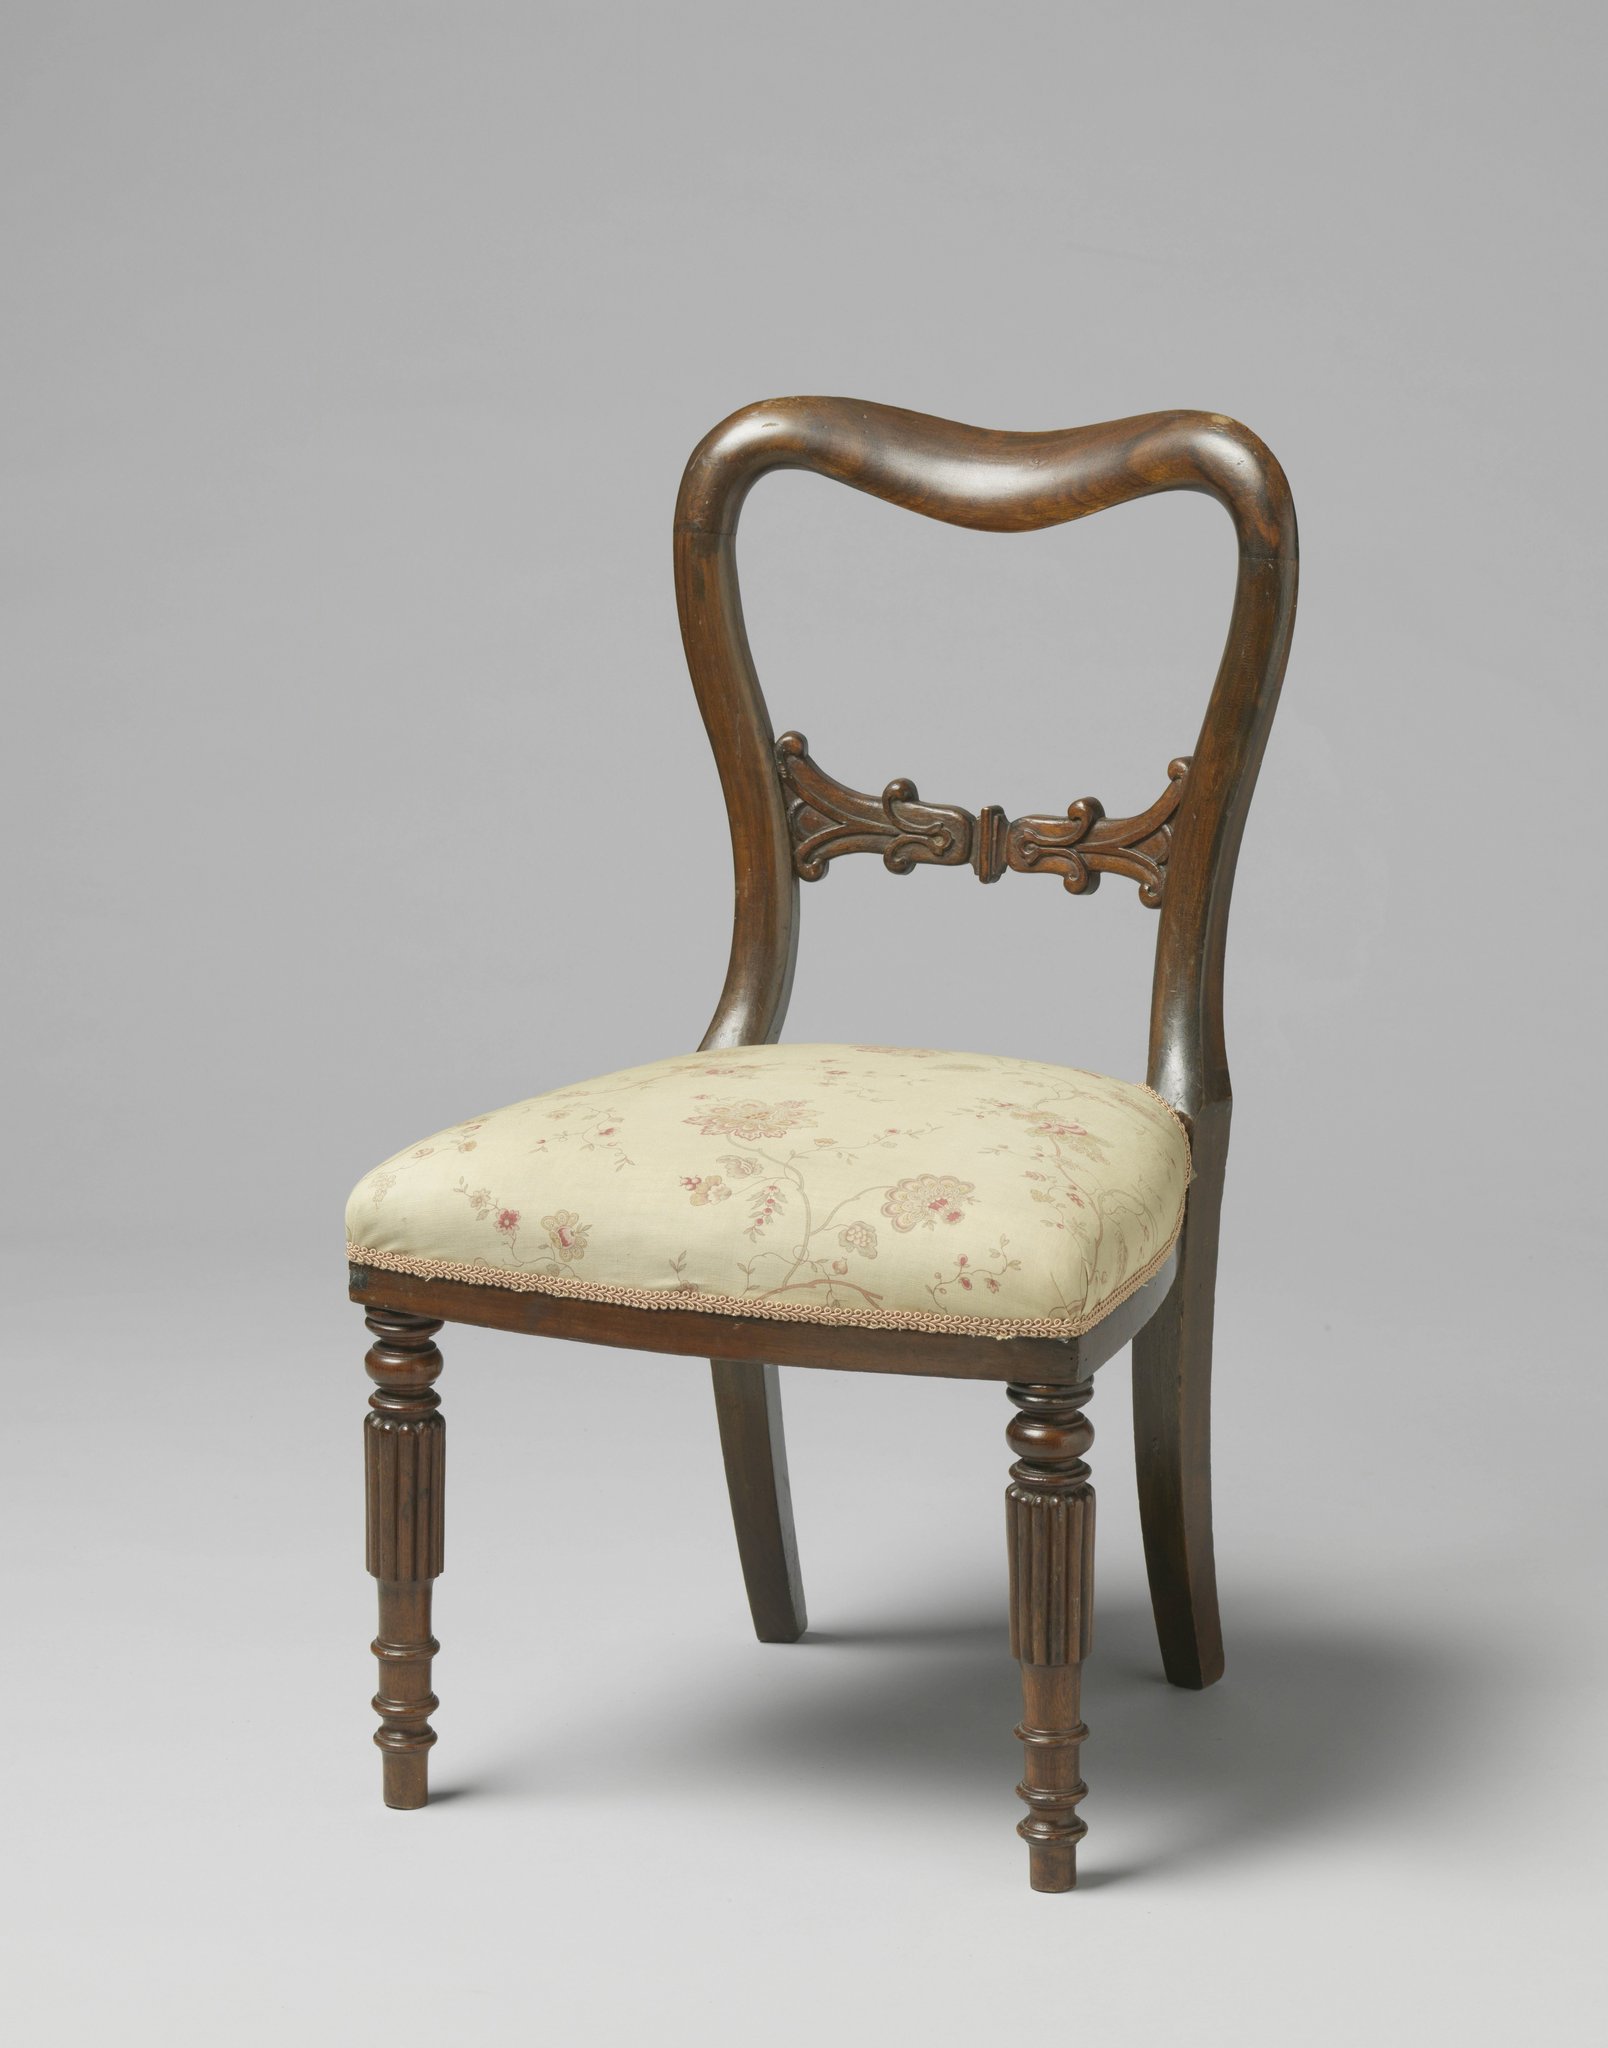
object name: seating furniture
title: Meubilair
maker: Anonymous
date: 1850-1875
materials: wood, textile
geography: netherlands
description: Stoel uit mahoniehouten kinderameublement bestaande uit drie stoelen en twee armstoelen. De ronde voorpoten zijn versierd met draaiwerk en met een rand van halfronde profielen. De sabelvormige achterpoten lopen over in het rugraam met gebogen stijlen en bovendorpel en met een tussenregel, versierd met symmetrisch geplaatste bladkelken, waartussen een verticaal geprofileerd sluitstuk. De S-vormige armleggers en stutten eindigen in een voluut; de onderzijde van de stutten dragen halfronde profielen. Beklede zitting.